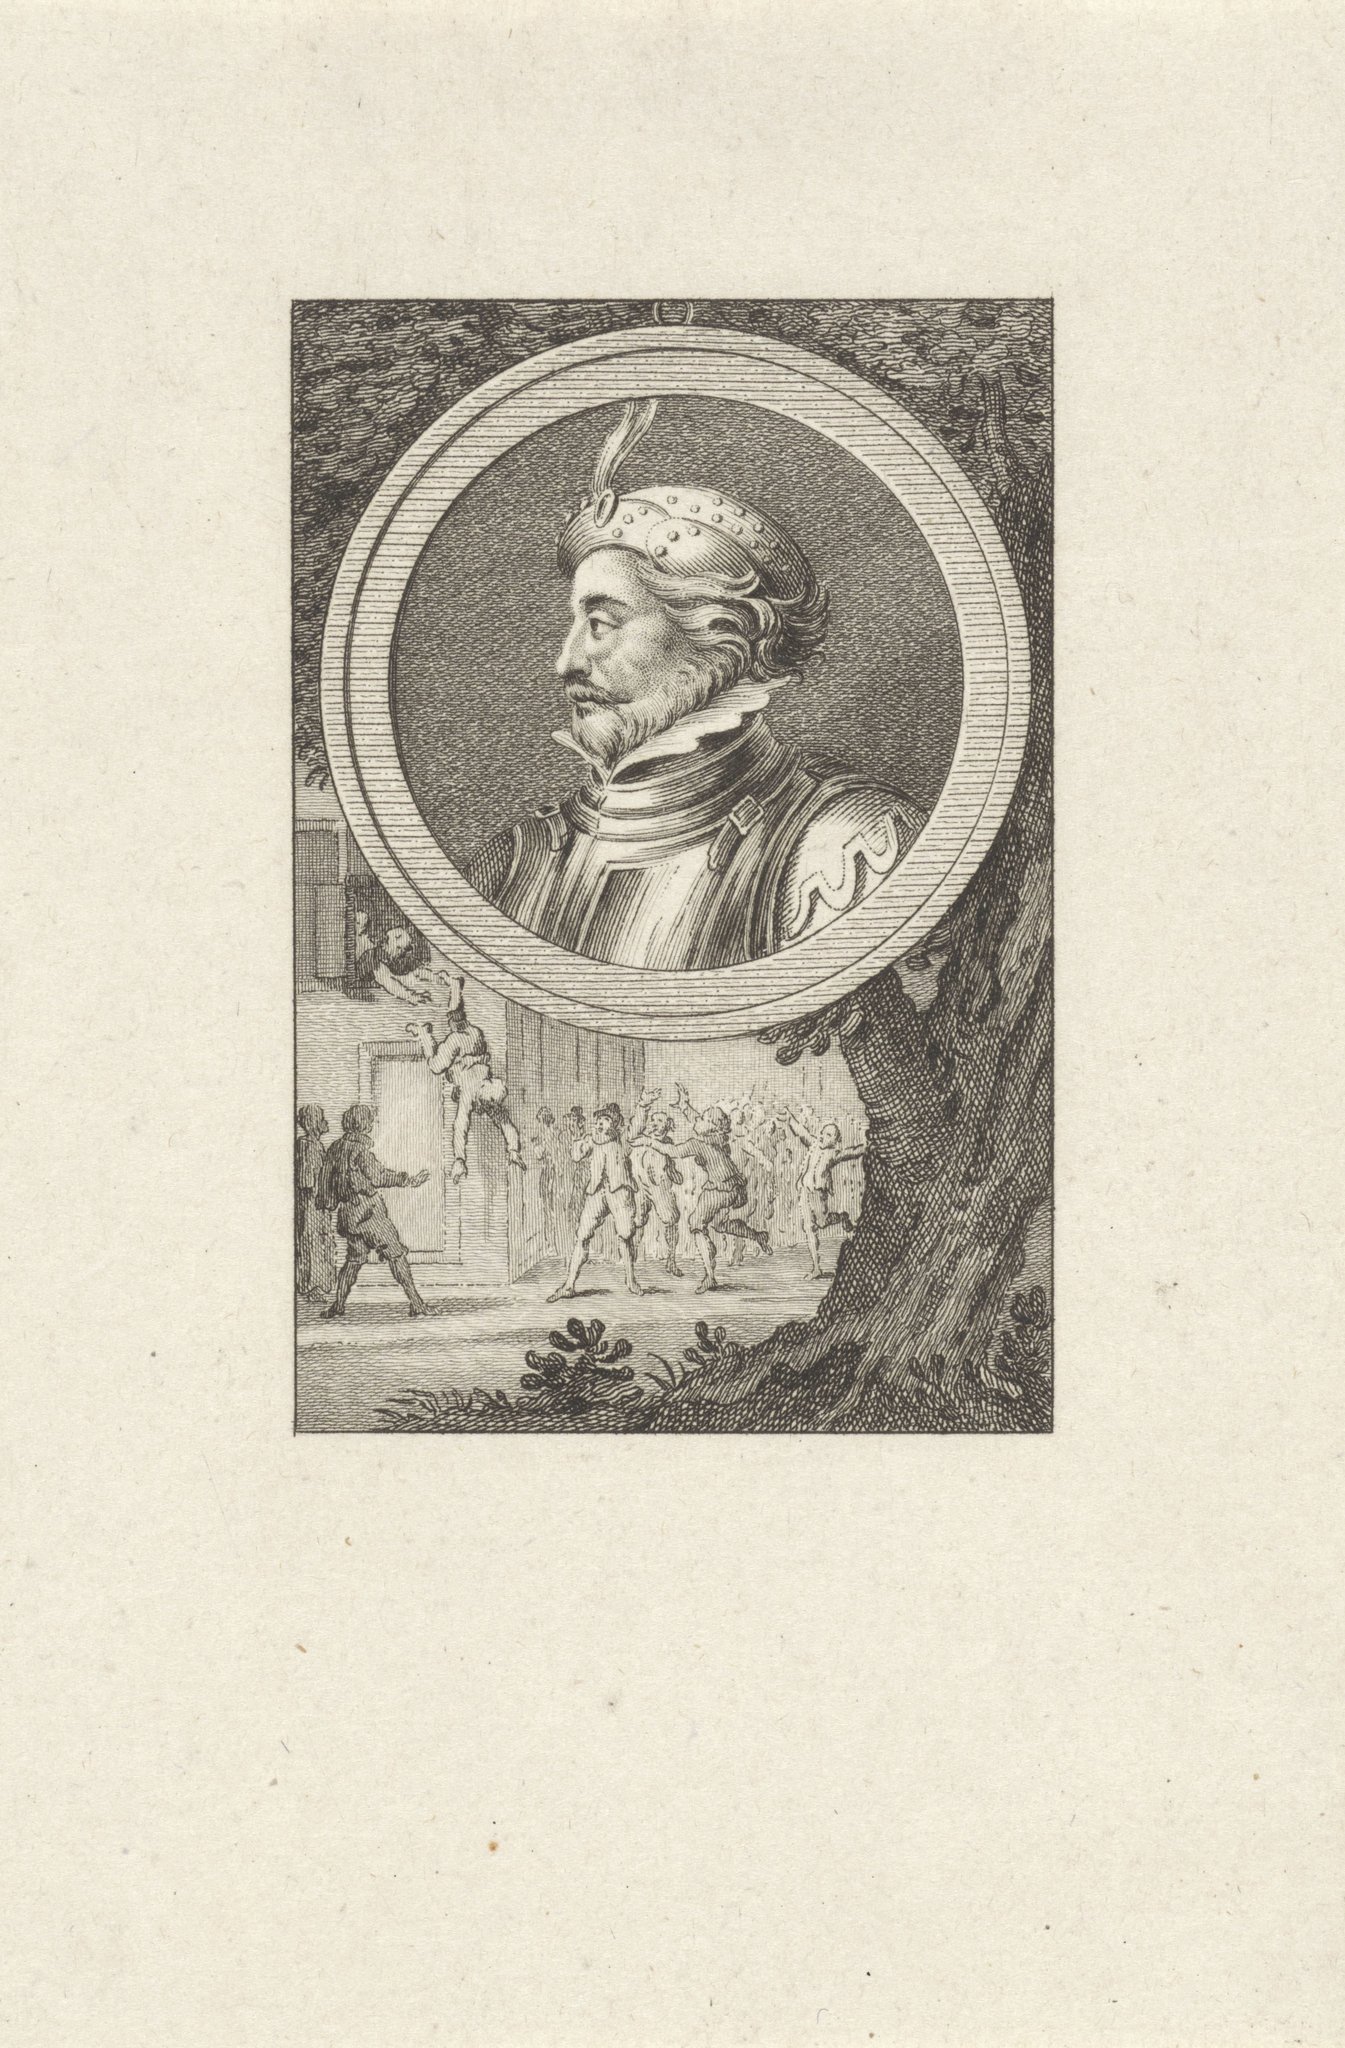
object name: print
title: Portret van Wolfert I van Borselen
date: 1783-1795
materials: paper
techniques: engraving, etching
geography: amsterdam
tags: delft, lynching, attempt, political murder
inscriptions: collector's mark: Lugt 2228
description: Latere staat prent gebruikt in: Fokke, Jan. Geschiedenissen der Vereenigde Nederlanden voor de vaderlandsche jeugd Ie-XXVste deel. Amsterdam: Johannes Allart, 1783-1795. Deel II.